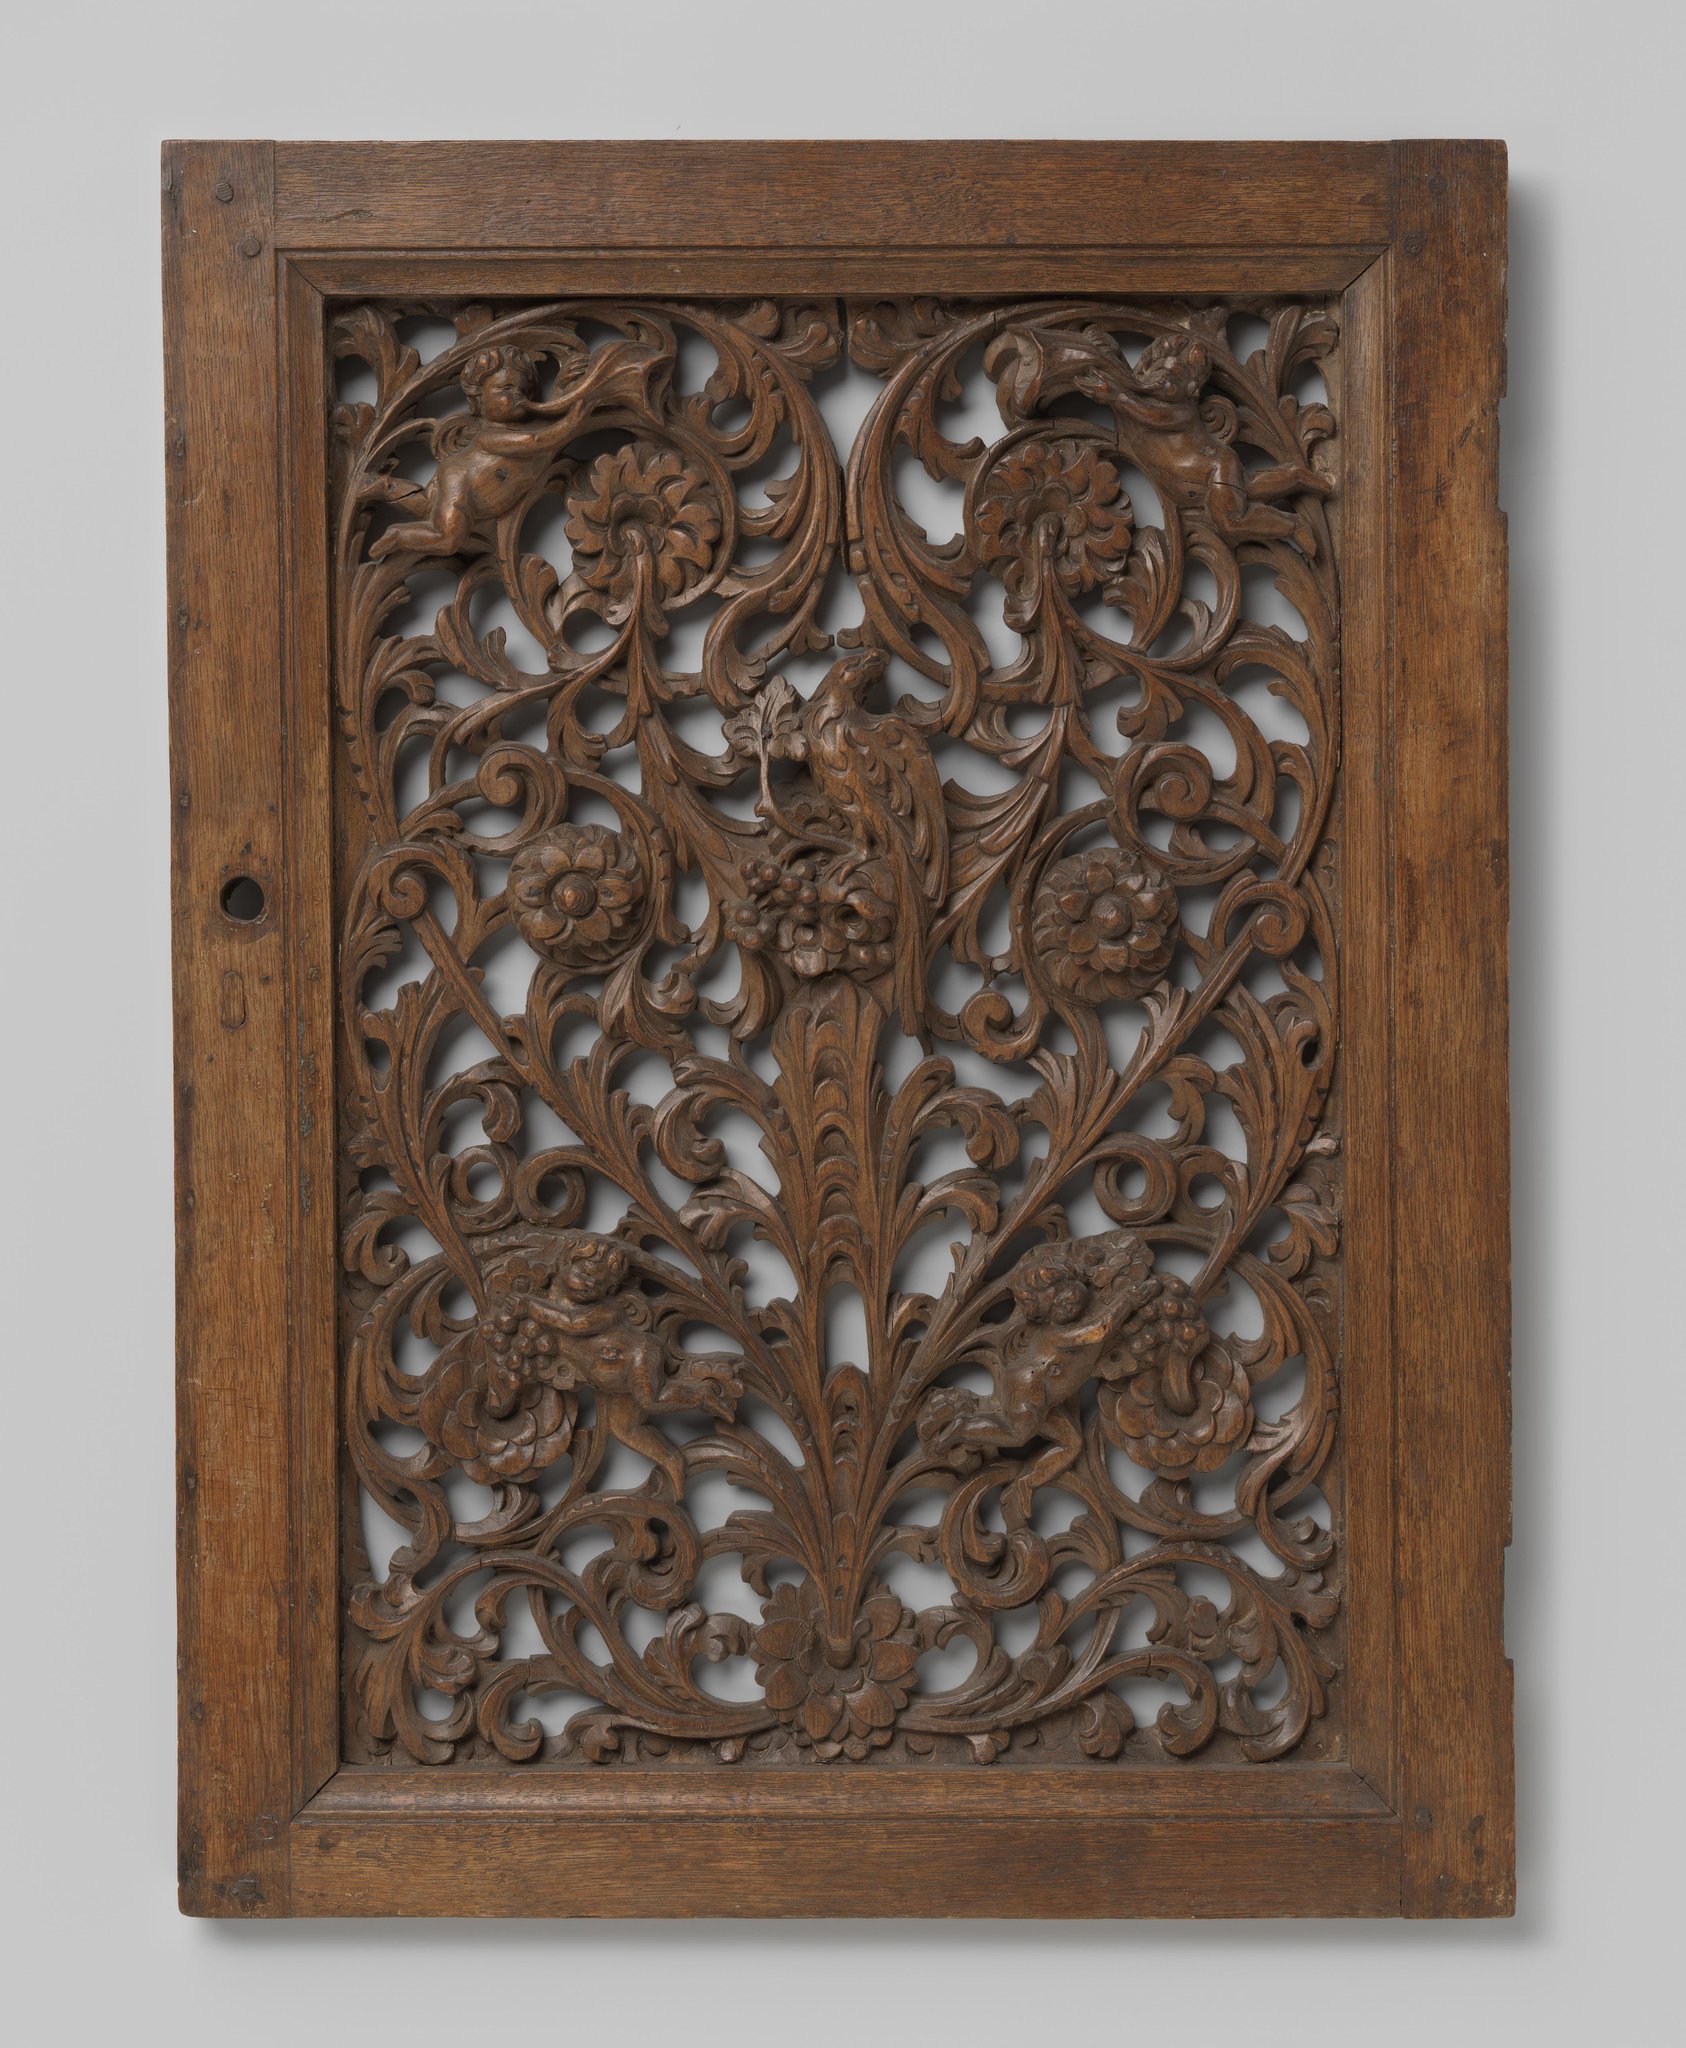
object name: furniture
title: Paneel met opengewerkt symmetrisch ornament van acanthusranken met bloemen en putti en in het midden een adelaar op bloem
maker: Anonymous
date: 1650-1699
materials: wood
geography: enkhuizen